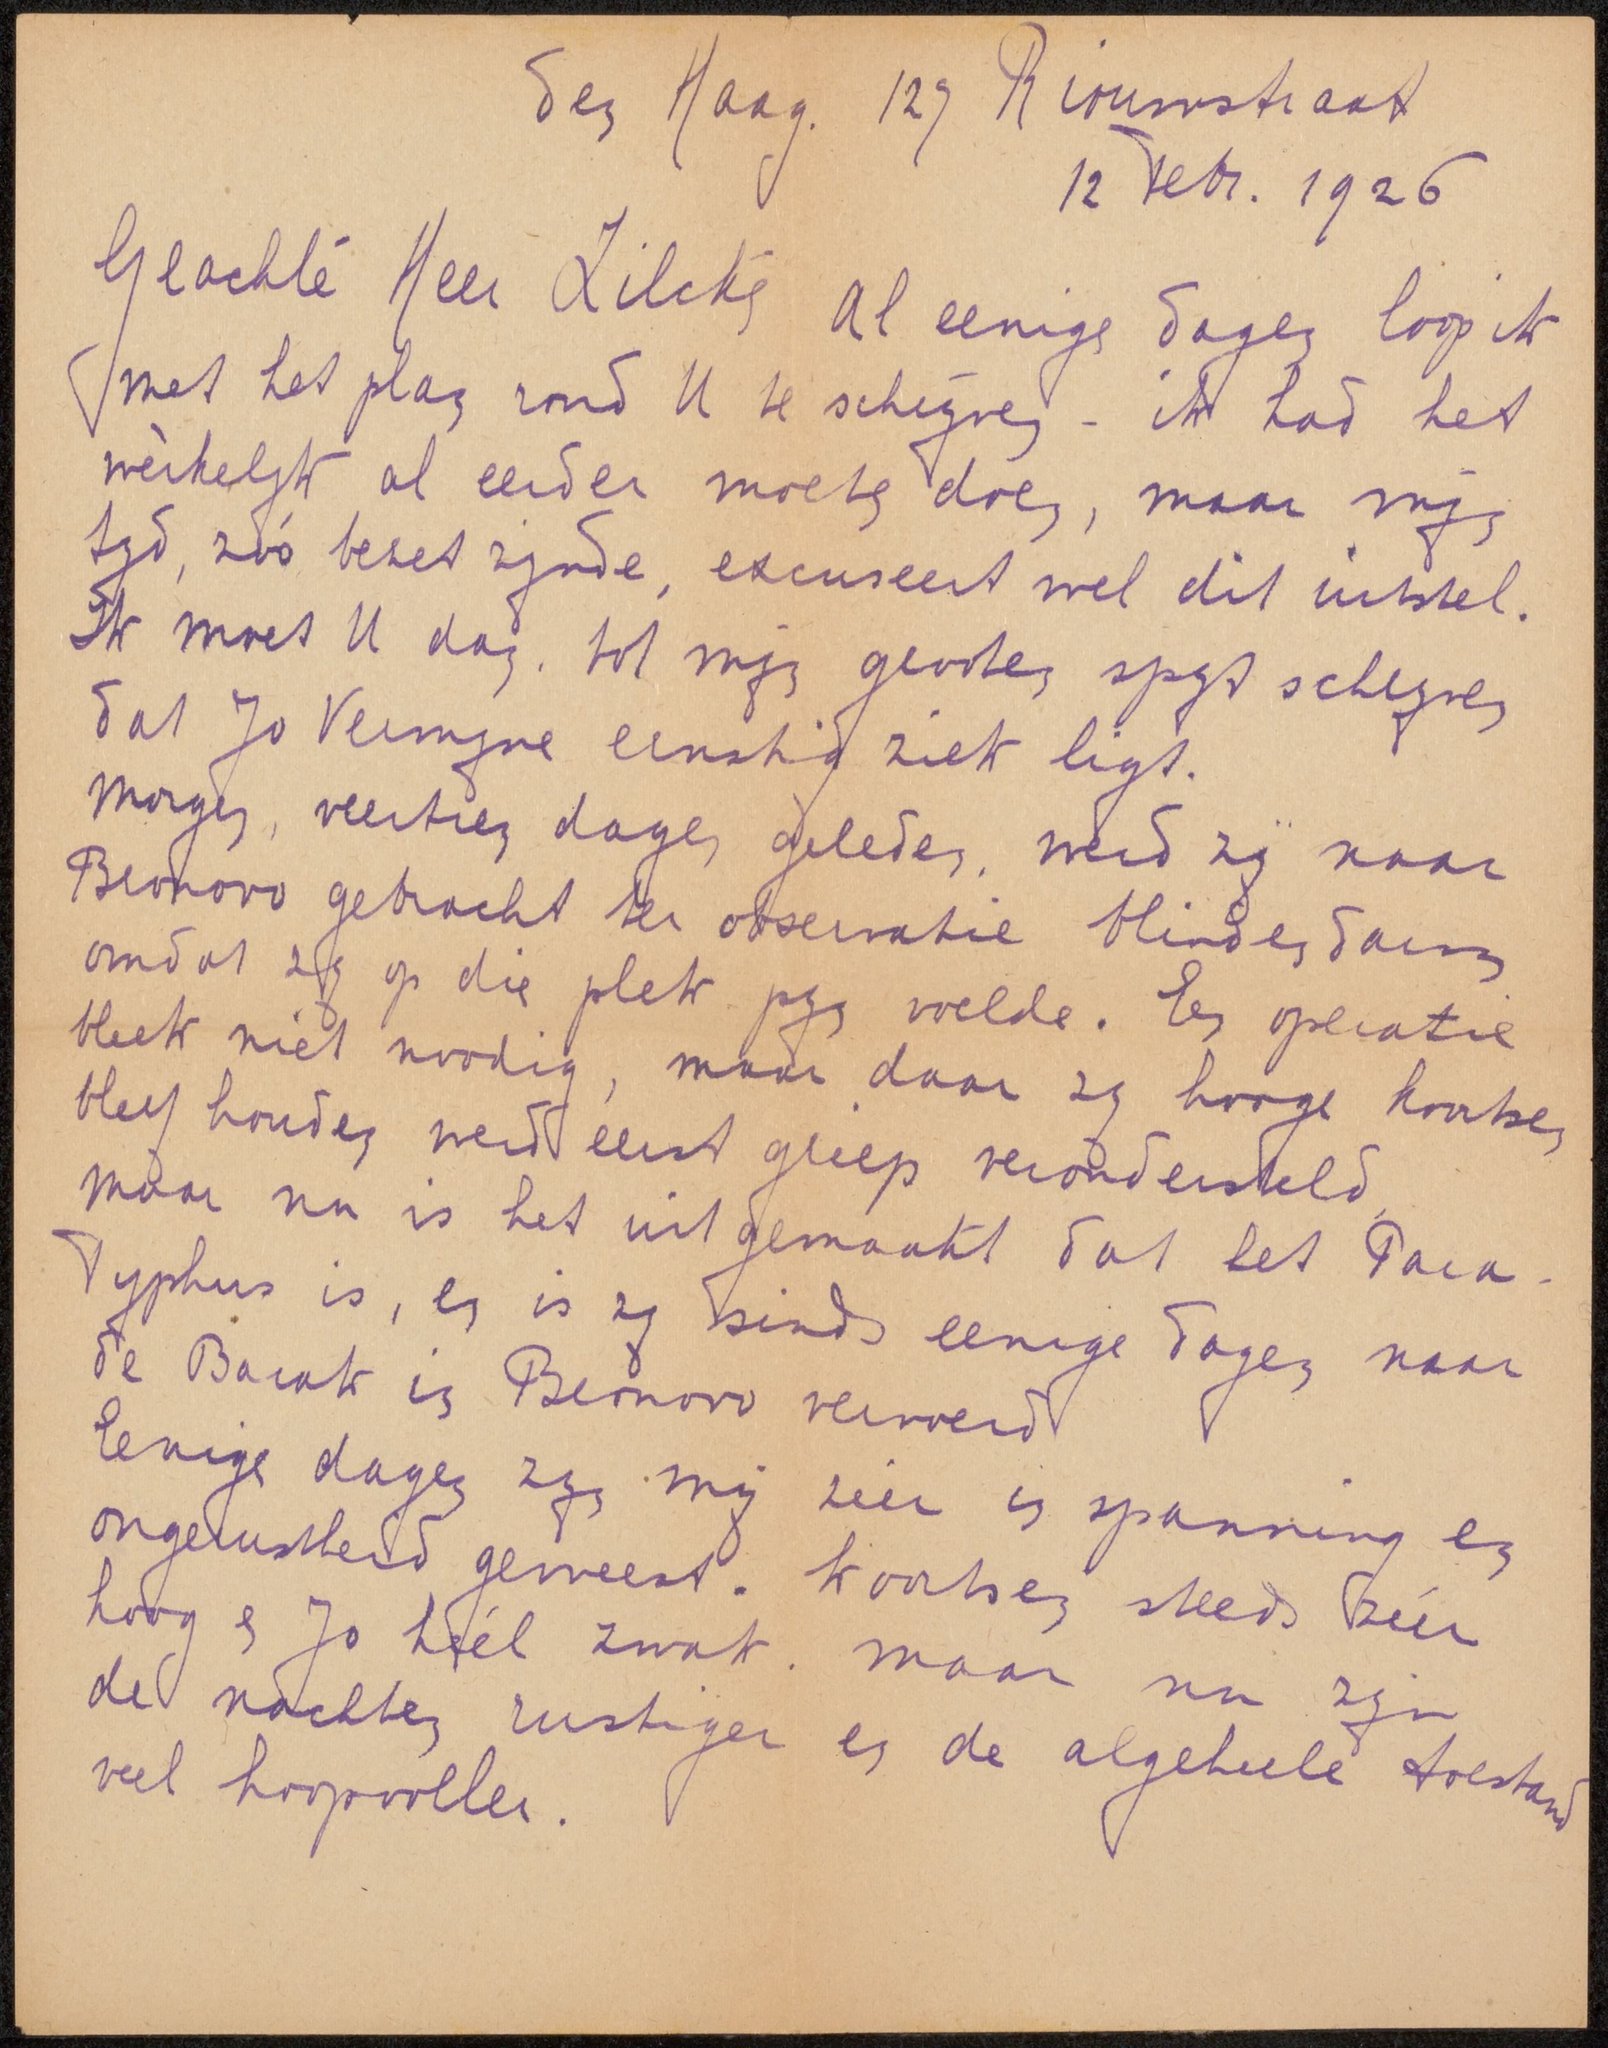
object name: letter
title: Brief aan Philip Zilcken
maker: c. hinlopen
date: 1926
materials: ink, paper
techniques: pen, writing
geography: the hague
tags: print maker, jo vermijne, painter, draughtsman, philip zilcken, diseases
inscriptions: collector's mark: ‘RPK’